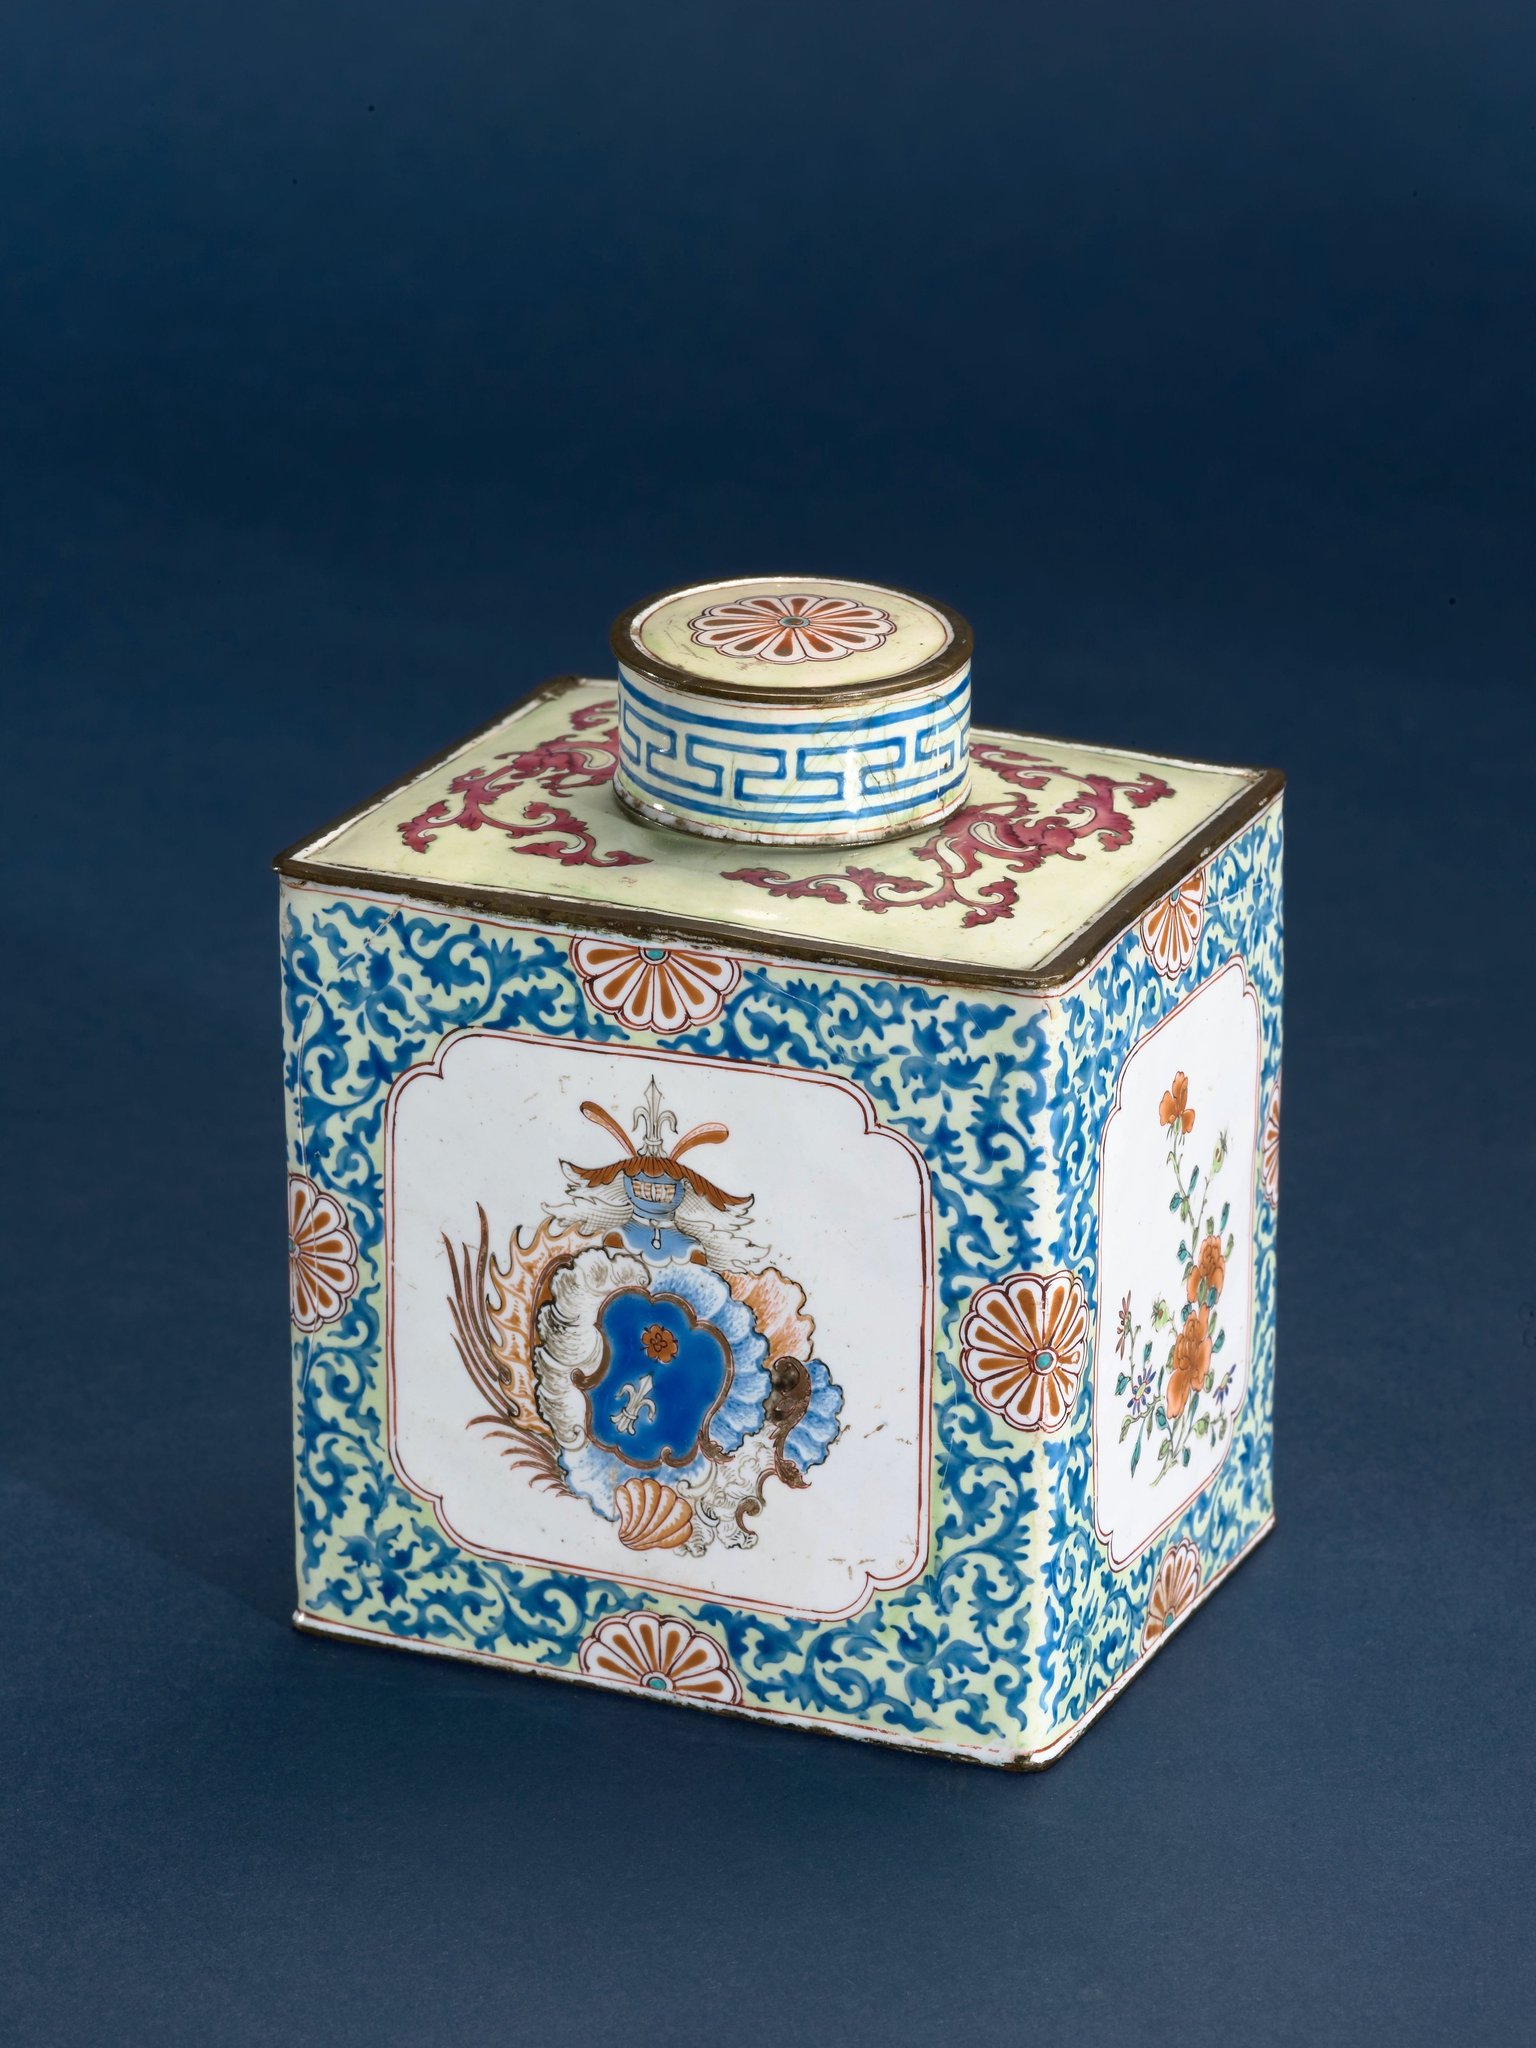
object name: tea caddy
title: Two tea caddies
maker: Anonymous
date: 1750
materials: copper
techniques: enamel painting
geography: china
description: Eyso de Wendt was employed by the VOC. He left for the East Indies in 1734 and held various offices in Canton between 1746 and 1757. While there he ordered various armorial porcelain services as well as this copper tea caddy.